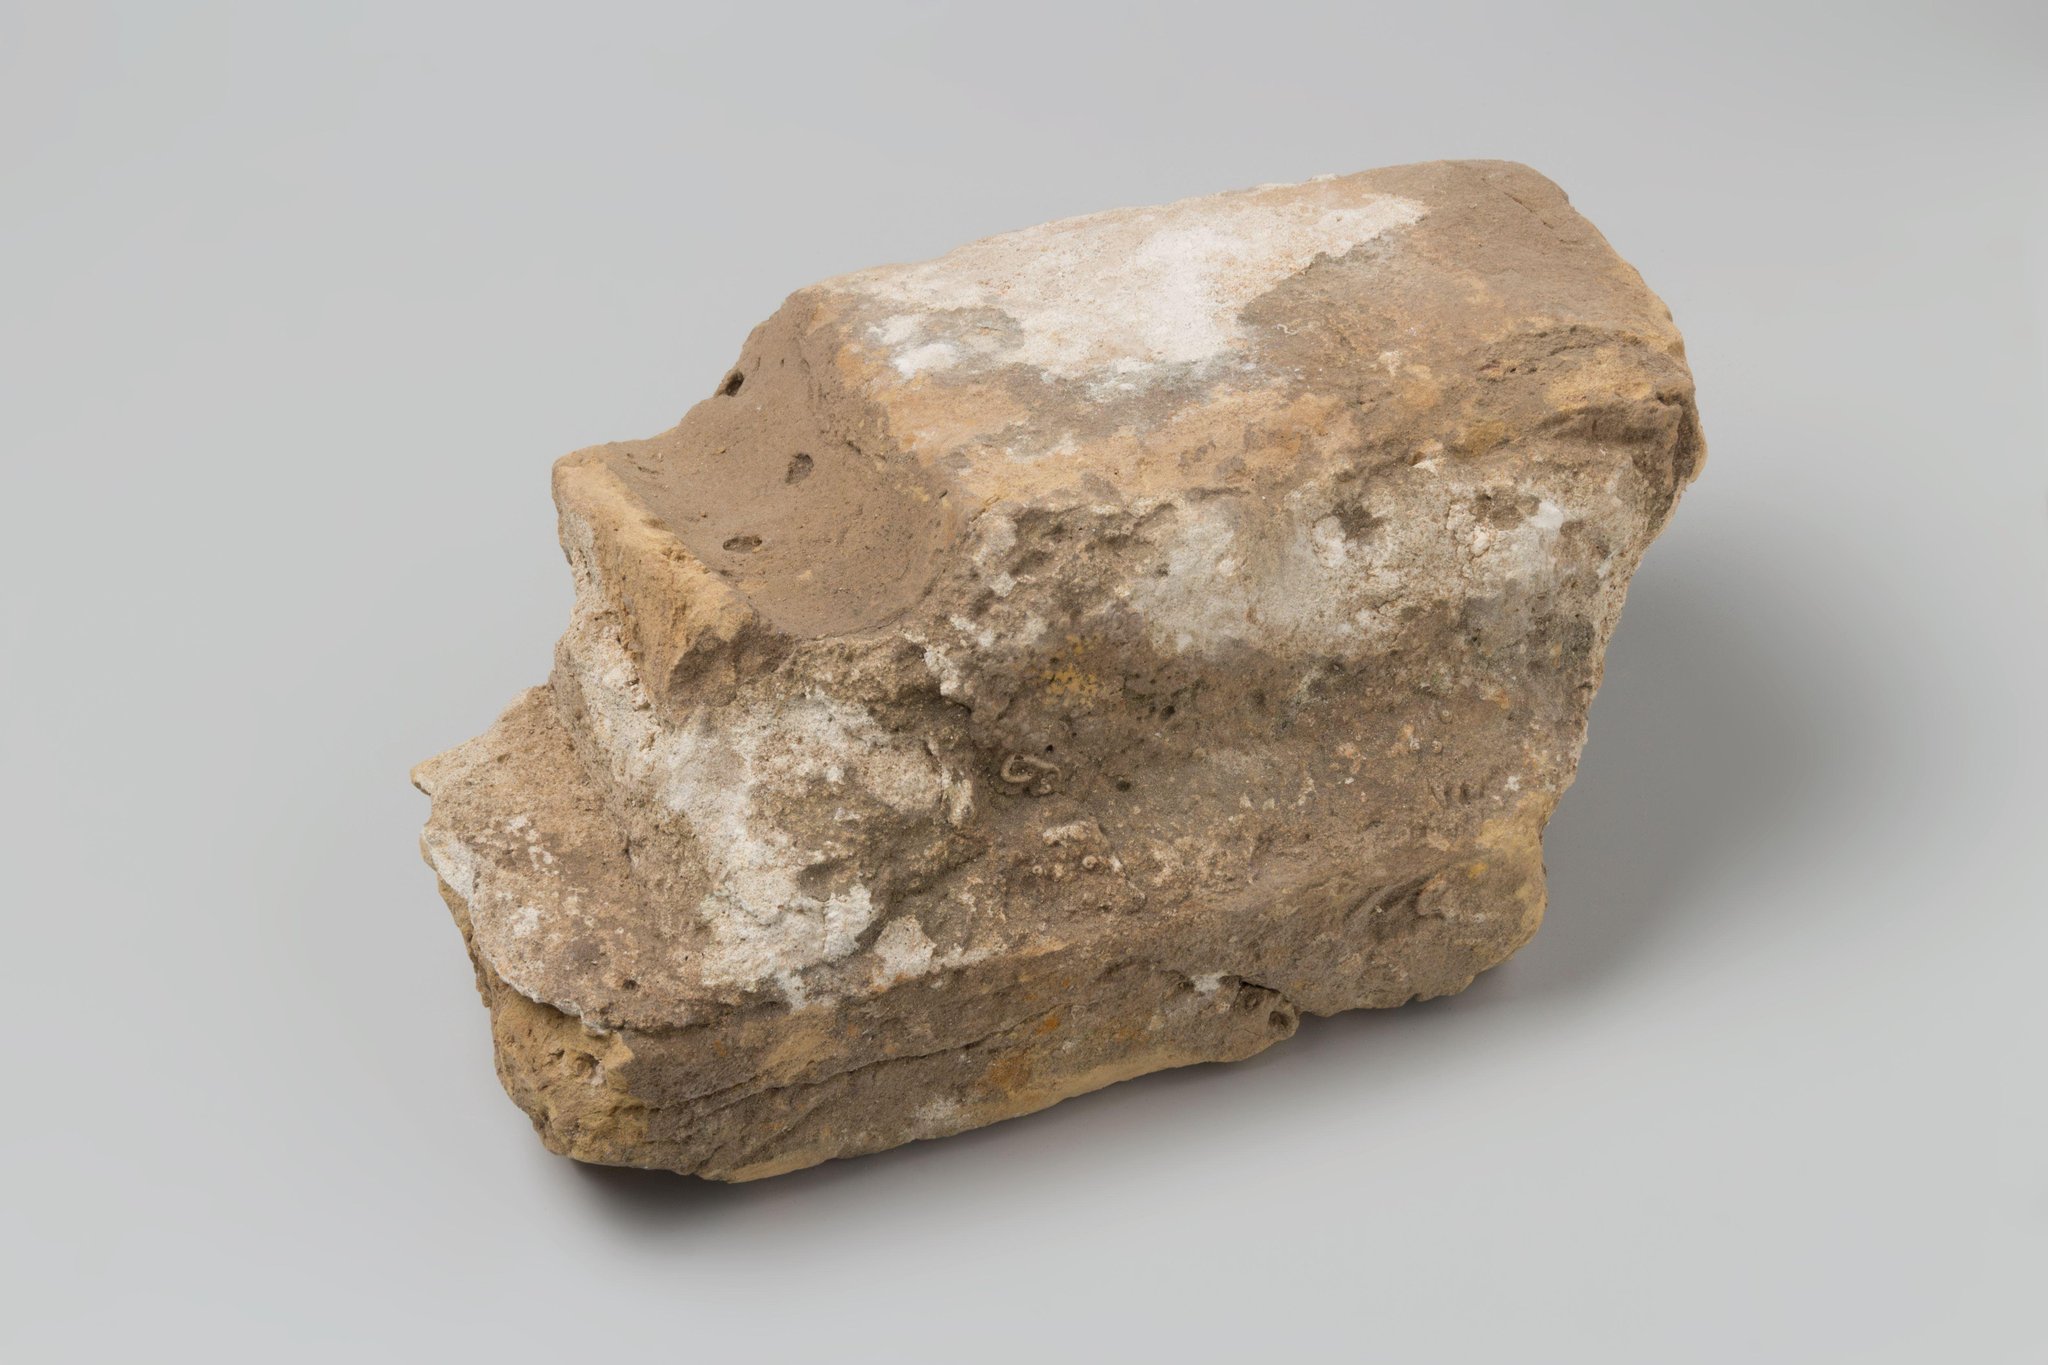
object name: brick clay product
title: Delen van twee aan elkaar gevormde bakstenen uit het wrak van de Oost-Indiëvaarder 't Vliegend Hart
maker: Anonymous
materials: brick, stone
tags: 't vliegend hart (schip), verenigde oostindische compagnie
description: Bijna twee complete geelbruine, rechthoekige baksteen, aan elkaar "gesmolten" door concretie. Brick.